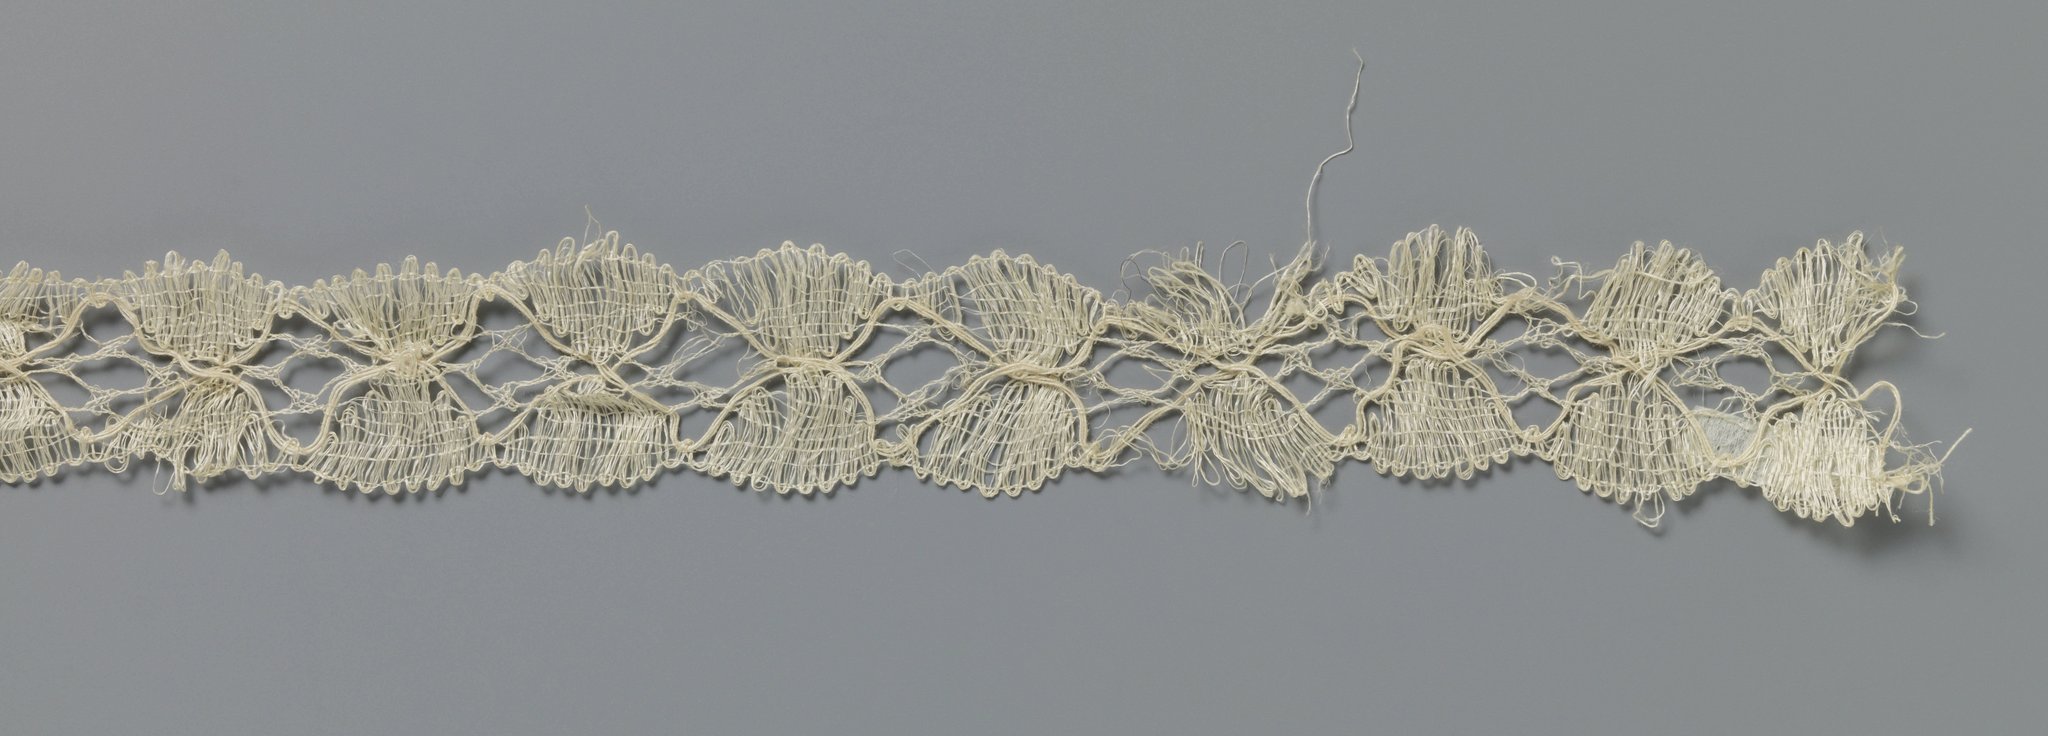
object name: strip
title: Strook kloskant met ruitvormig veld tussen gespiegelde waaiers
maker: Anonymous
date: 1840-1860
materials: silk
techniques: lace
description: Strook naturelkleurige kloskant, blonde. Het zich herhalende patroon bestaat uit een over de lengte-as gespiegelde waaier, die aan de boven- en onderzijde van de strook schulpen vormen. Tussen de gespiegelde waaiers in wordt een opengewerkt ruitvormig veld gevormd, waarin een siergrond is toegepast. De ruiten zijn voorzien van doorlopende contourdraden, die elkaar kruisen op de lengte-as.